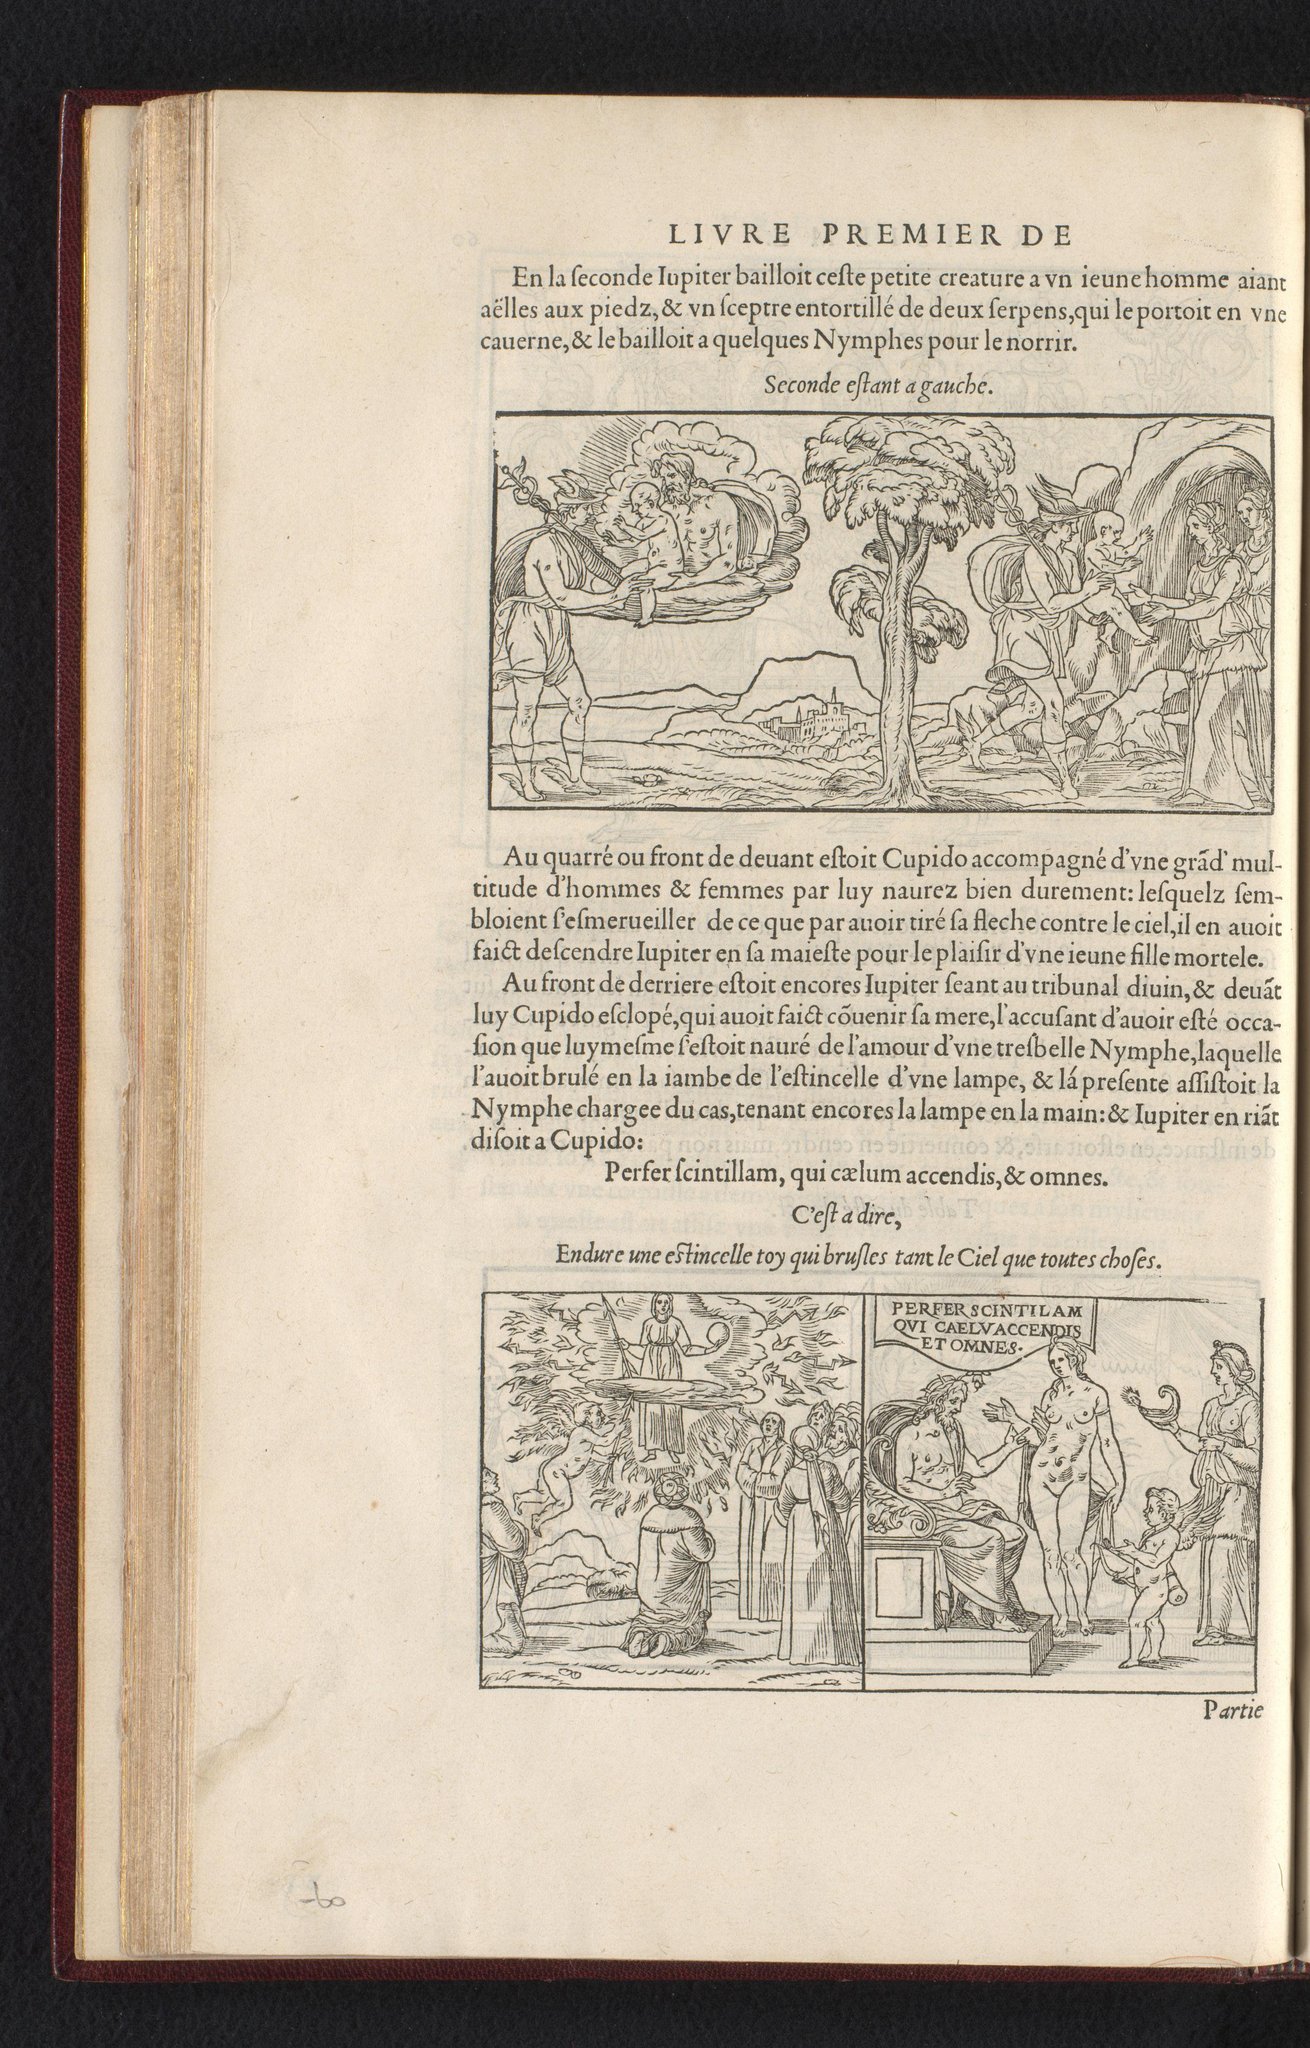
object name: page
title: Jupiter geeft een baby aan Mercurius die deze bij nimfen achterlaat, en twee scènes met Cupido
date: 1546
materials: paper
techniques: letterpress printing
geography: paris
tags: (story of) mercury (hermes), (story of) jupiter (zeus), (scenes from) specific works of literature: colonna, hypnerotomachia poliphili, nymphs (in general); 'ninfe in commune' (ripa), (story of) cupid, amor (eros)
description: Prent uit: Colonna, Francesco. Hypnerotomachie ou discours du songe de Poliphile, deduisant comme amour le combat a l'occasion de Polia. Parijs: Jacques Kerver, 1546, verso fol. 60.